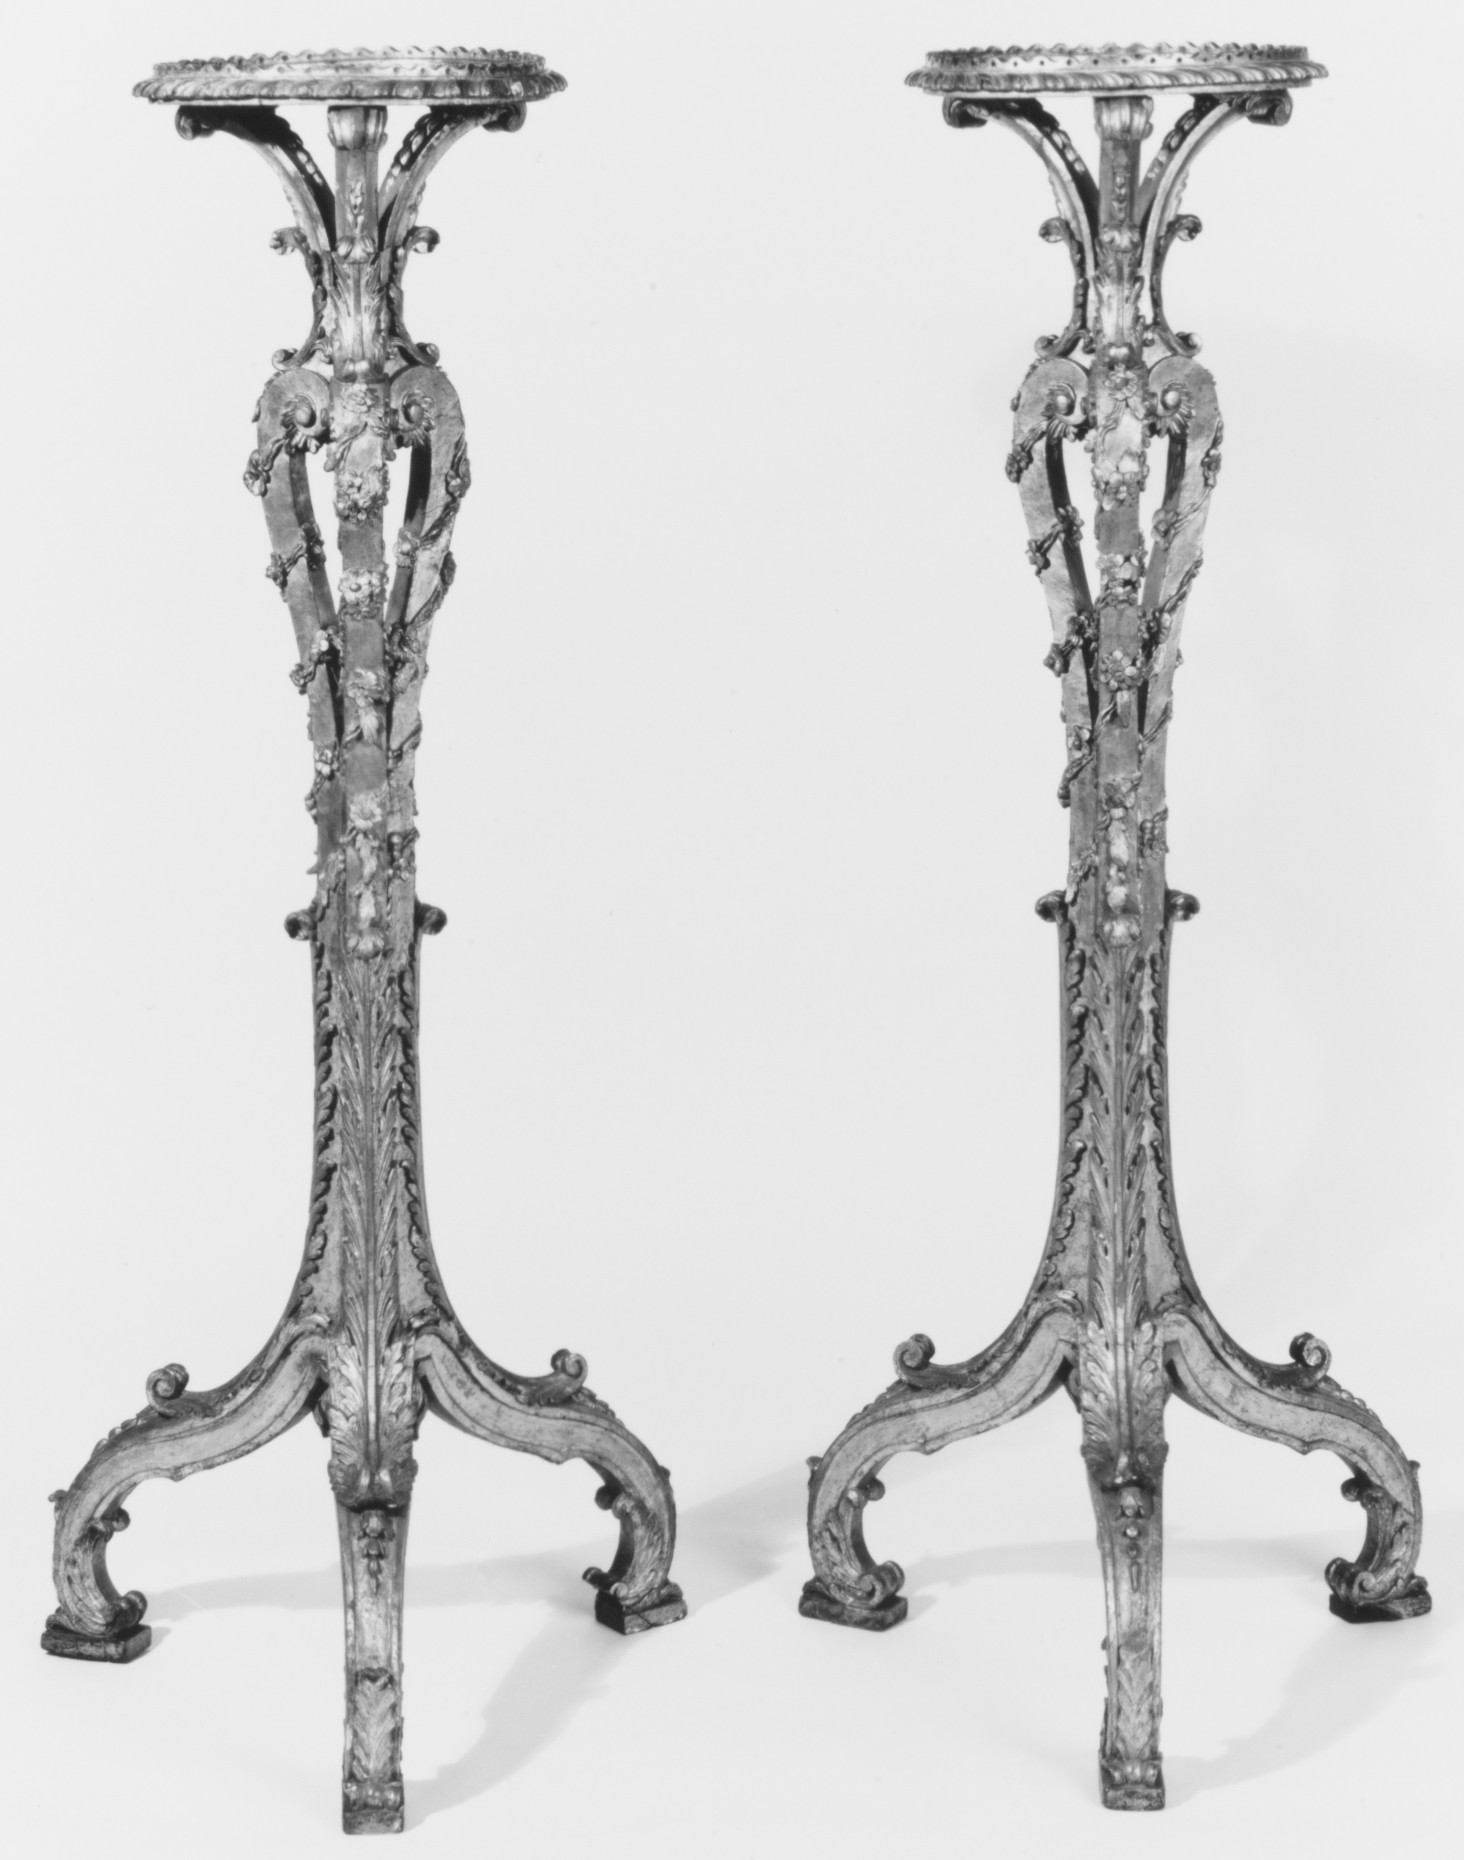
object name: tripod candlestands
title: Pair of tripod candlestands (torchères)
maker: françois de cuvilliés the younger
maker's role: designer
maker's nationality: german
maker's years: 1731-1777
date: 1740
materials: wood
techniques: carving, gilding